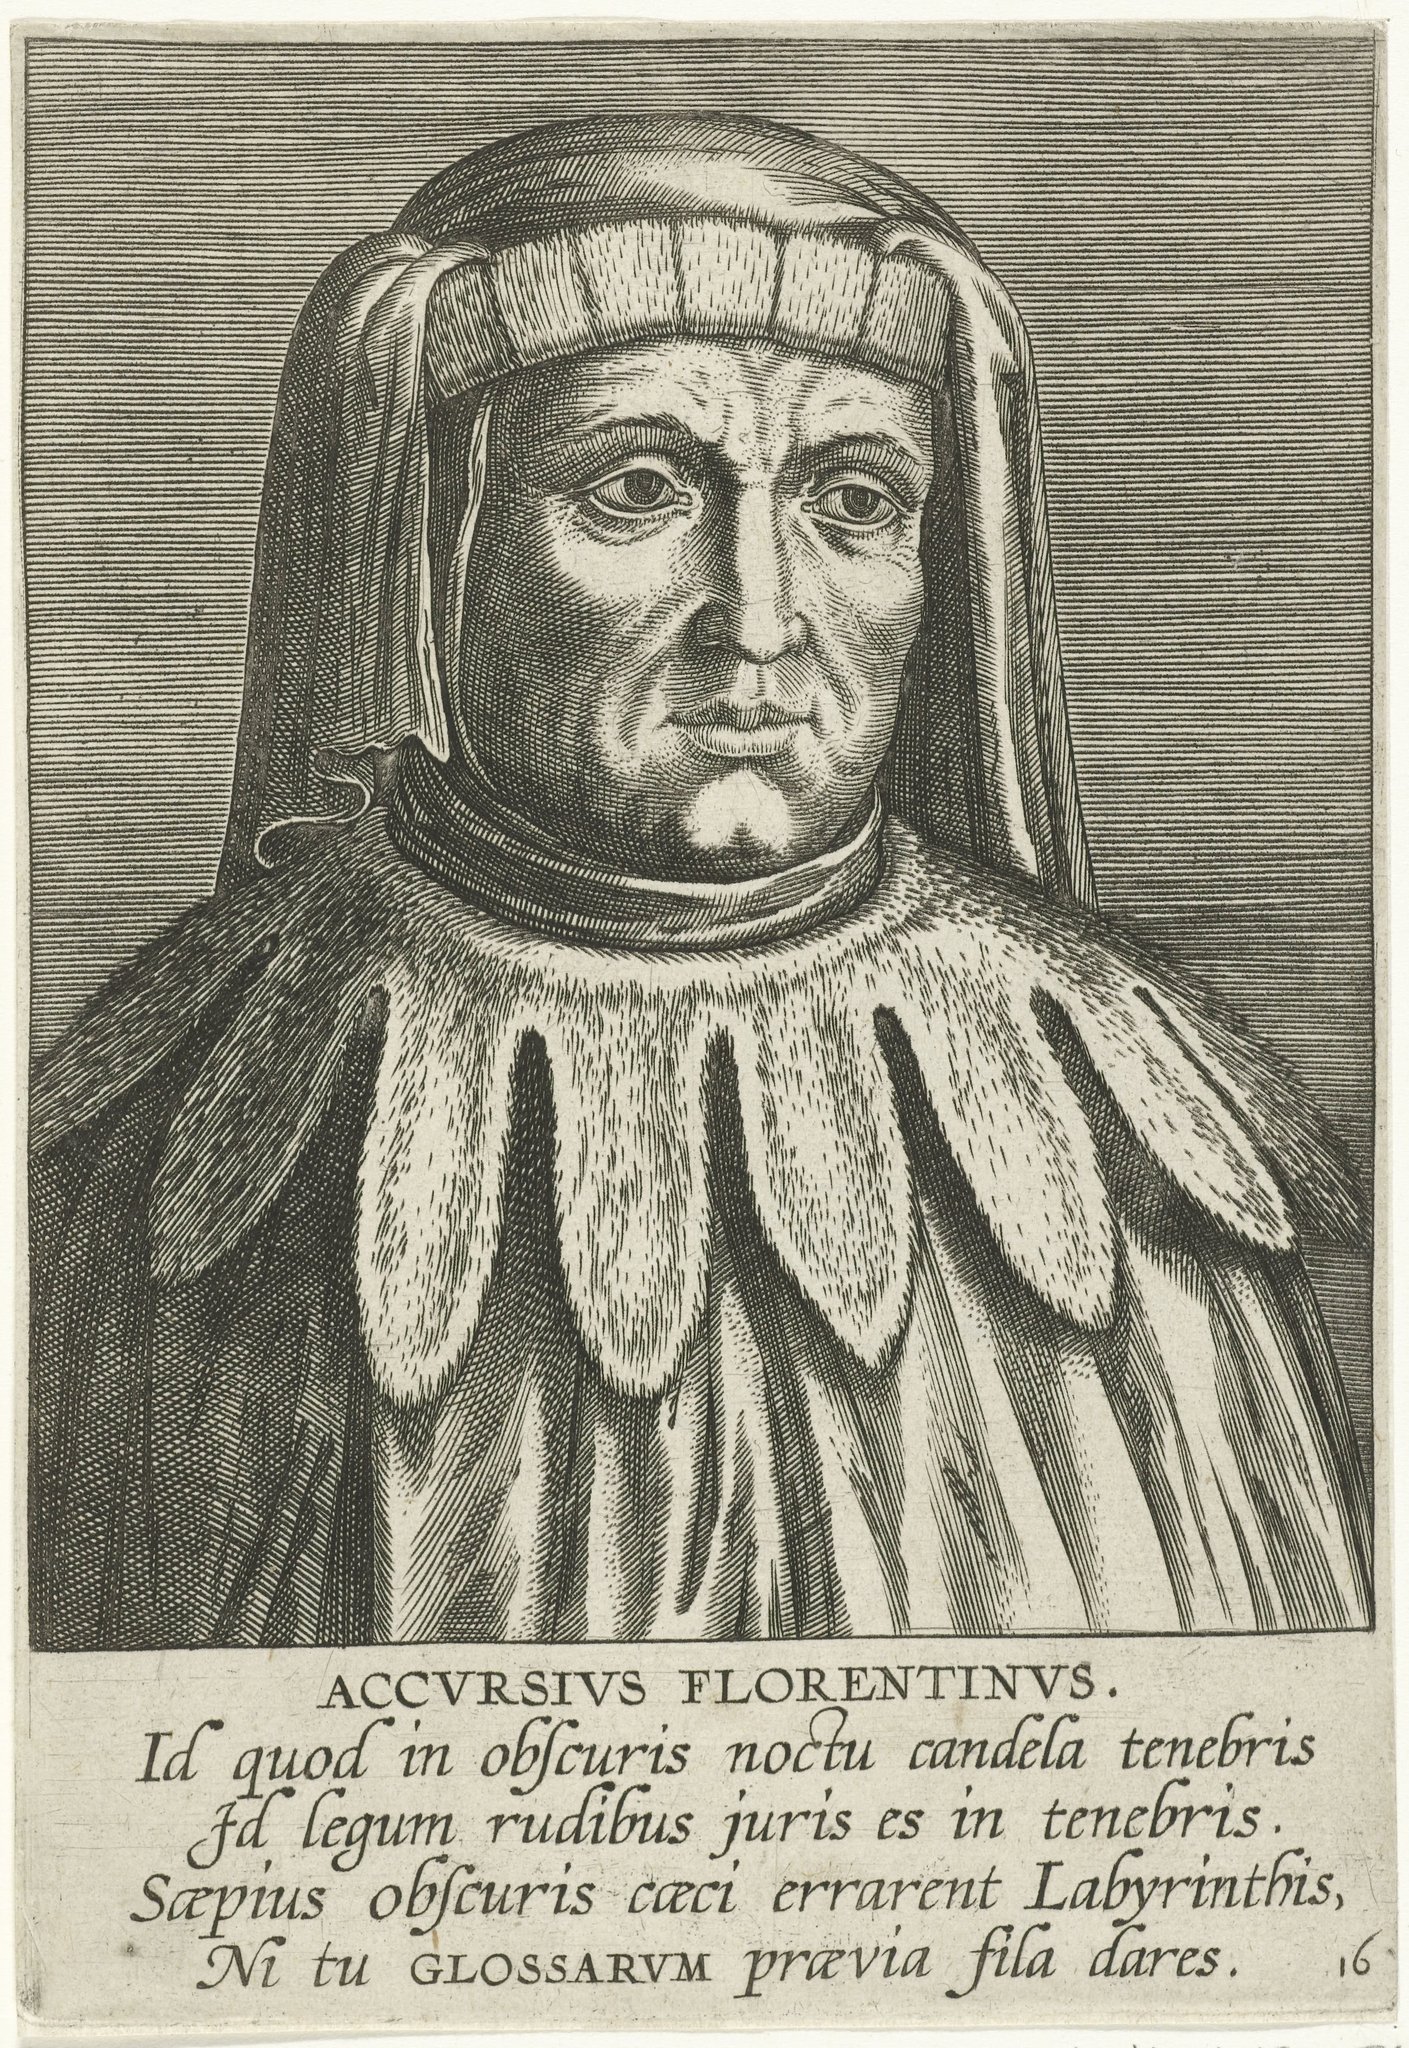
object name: print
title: Imagines L. doctorum virorum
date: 1587-1606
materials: paper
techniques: engraving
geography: antwerp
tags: jurist, accursius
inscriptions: collector's mark: Lugt 2228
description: Portret van Accursius van Firenze, een beroemde glossator uit de middeleeuwen. Buste naar rechts. De prent heeft een Latijns onderschrift en maakt deel uit van een serie van beroemde geleerden.